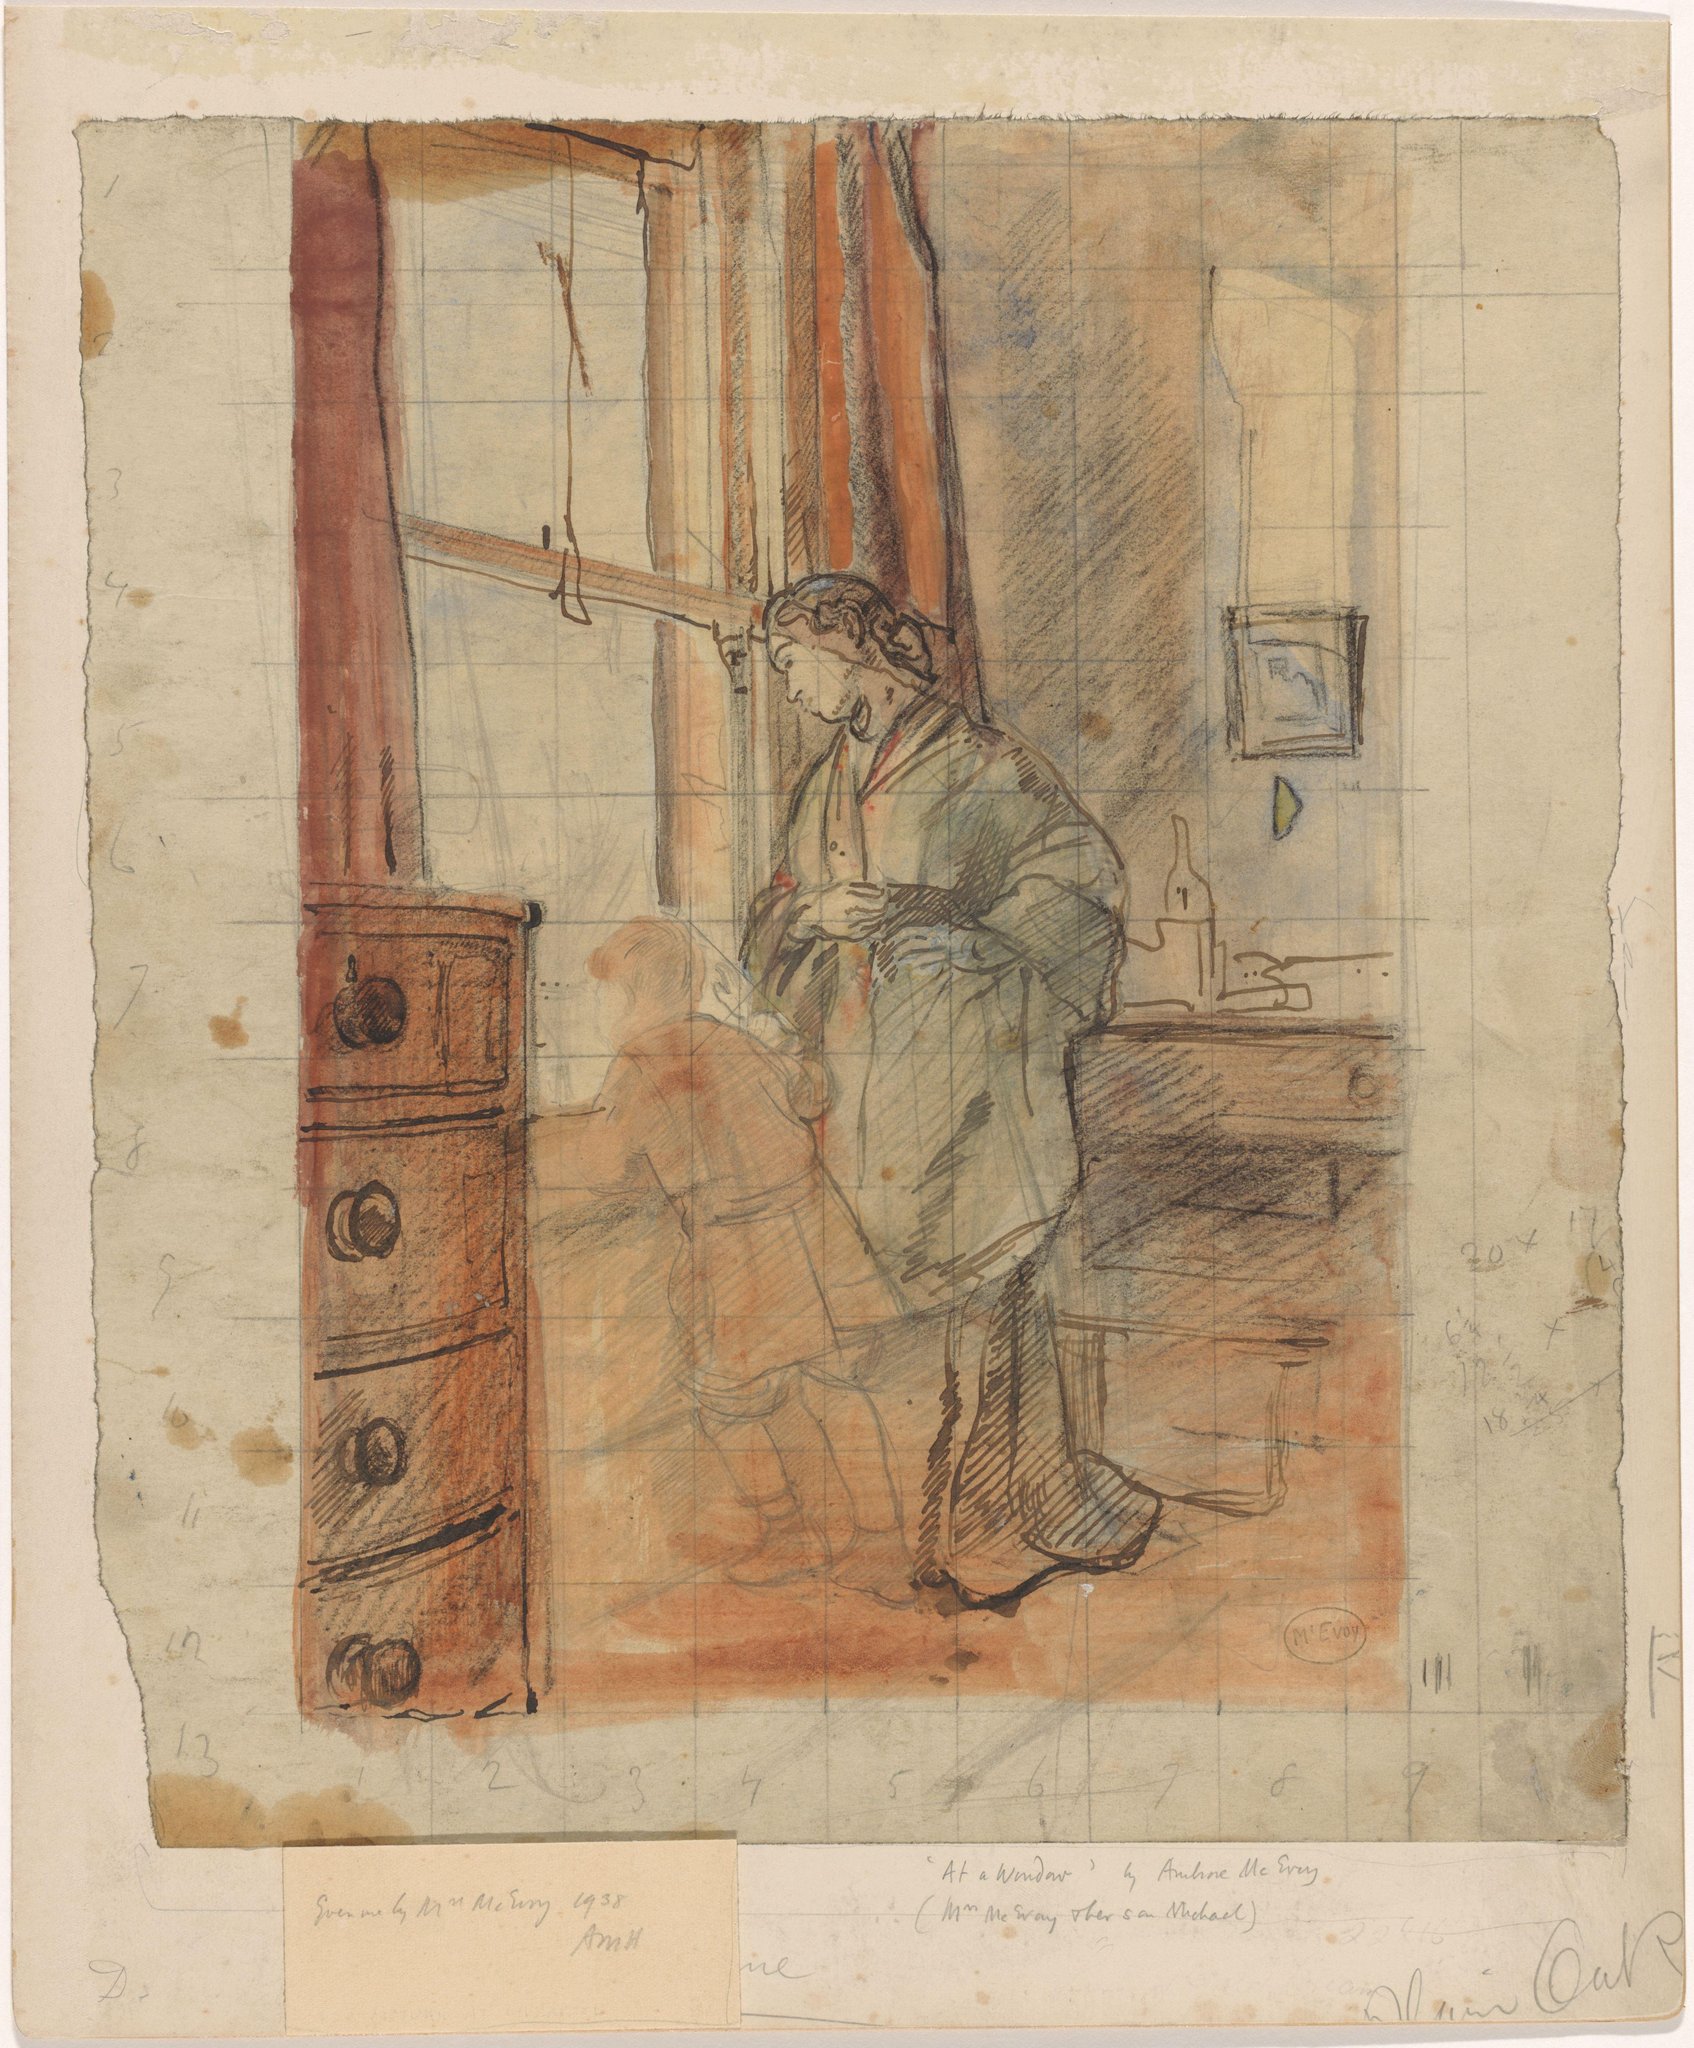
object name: drawing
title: Mrs. Mc Evoy en haar zoon Michael staande bij een raam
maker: ambrose arthur macevoy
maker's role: draughtsman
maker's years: 1878-1927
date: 1900-1927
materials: chalk, ink, paper, pencil, watercolor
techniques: brush, pen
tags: window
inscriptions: inscription: ‘At a window’